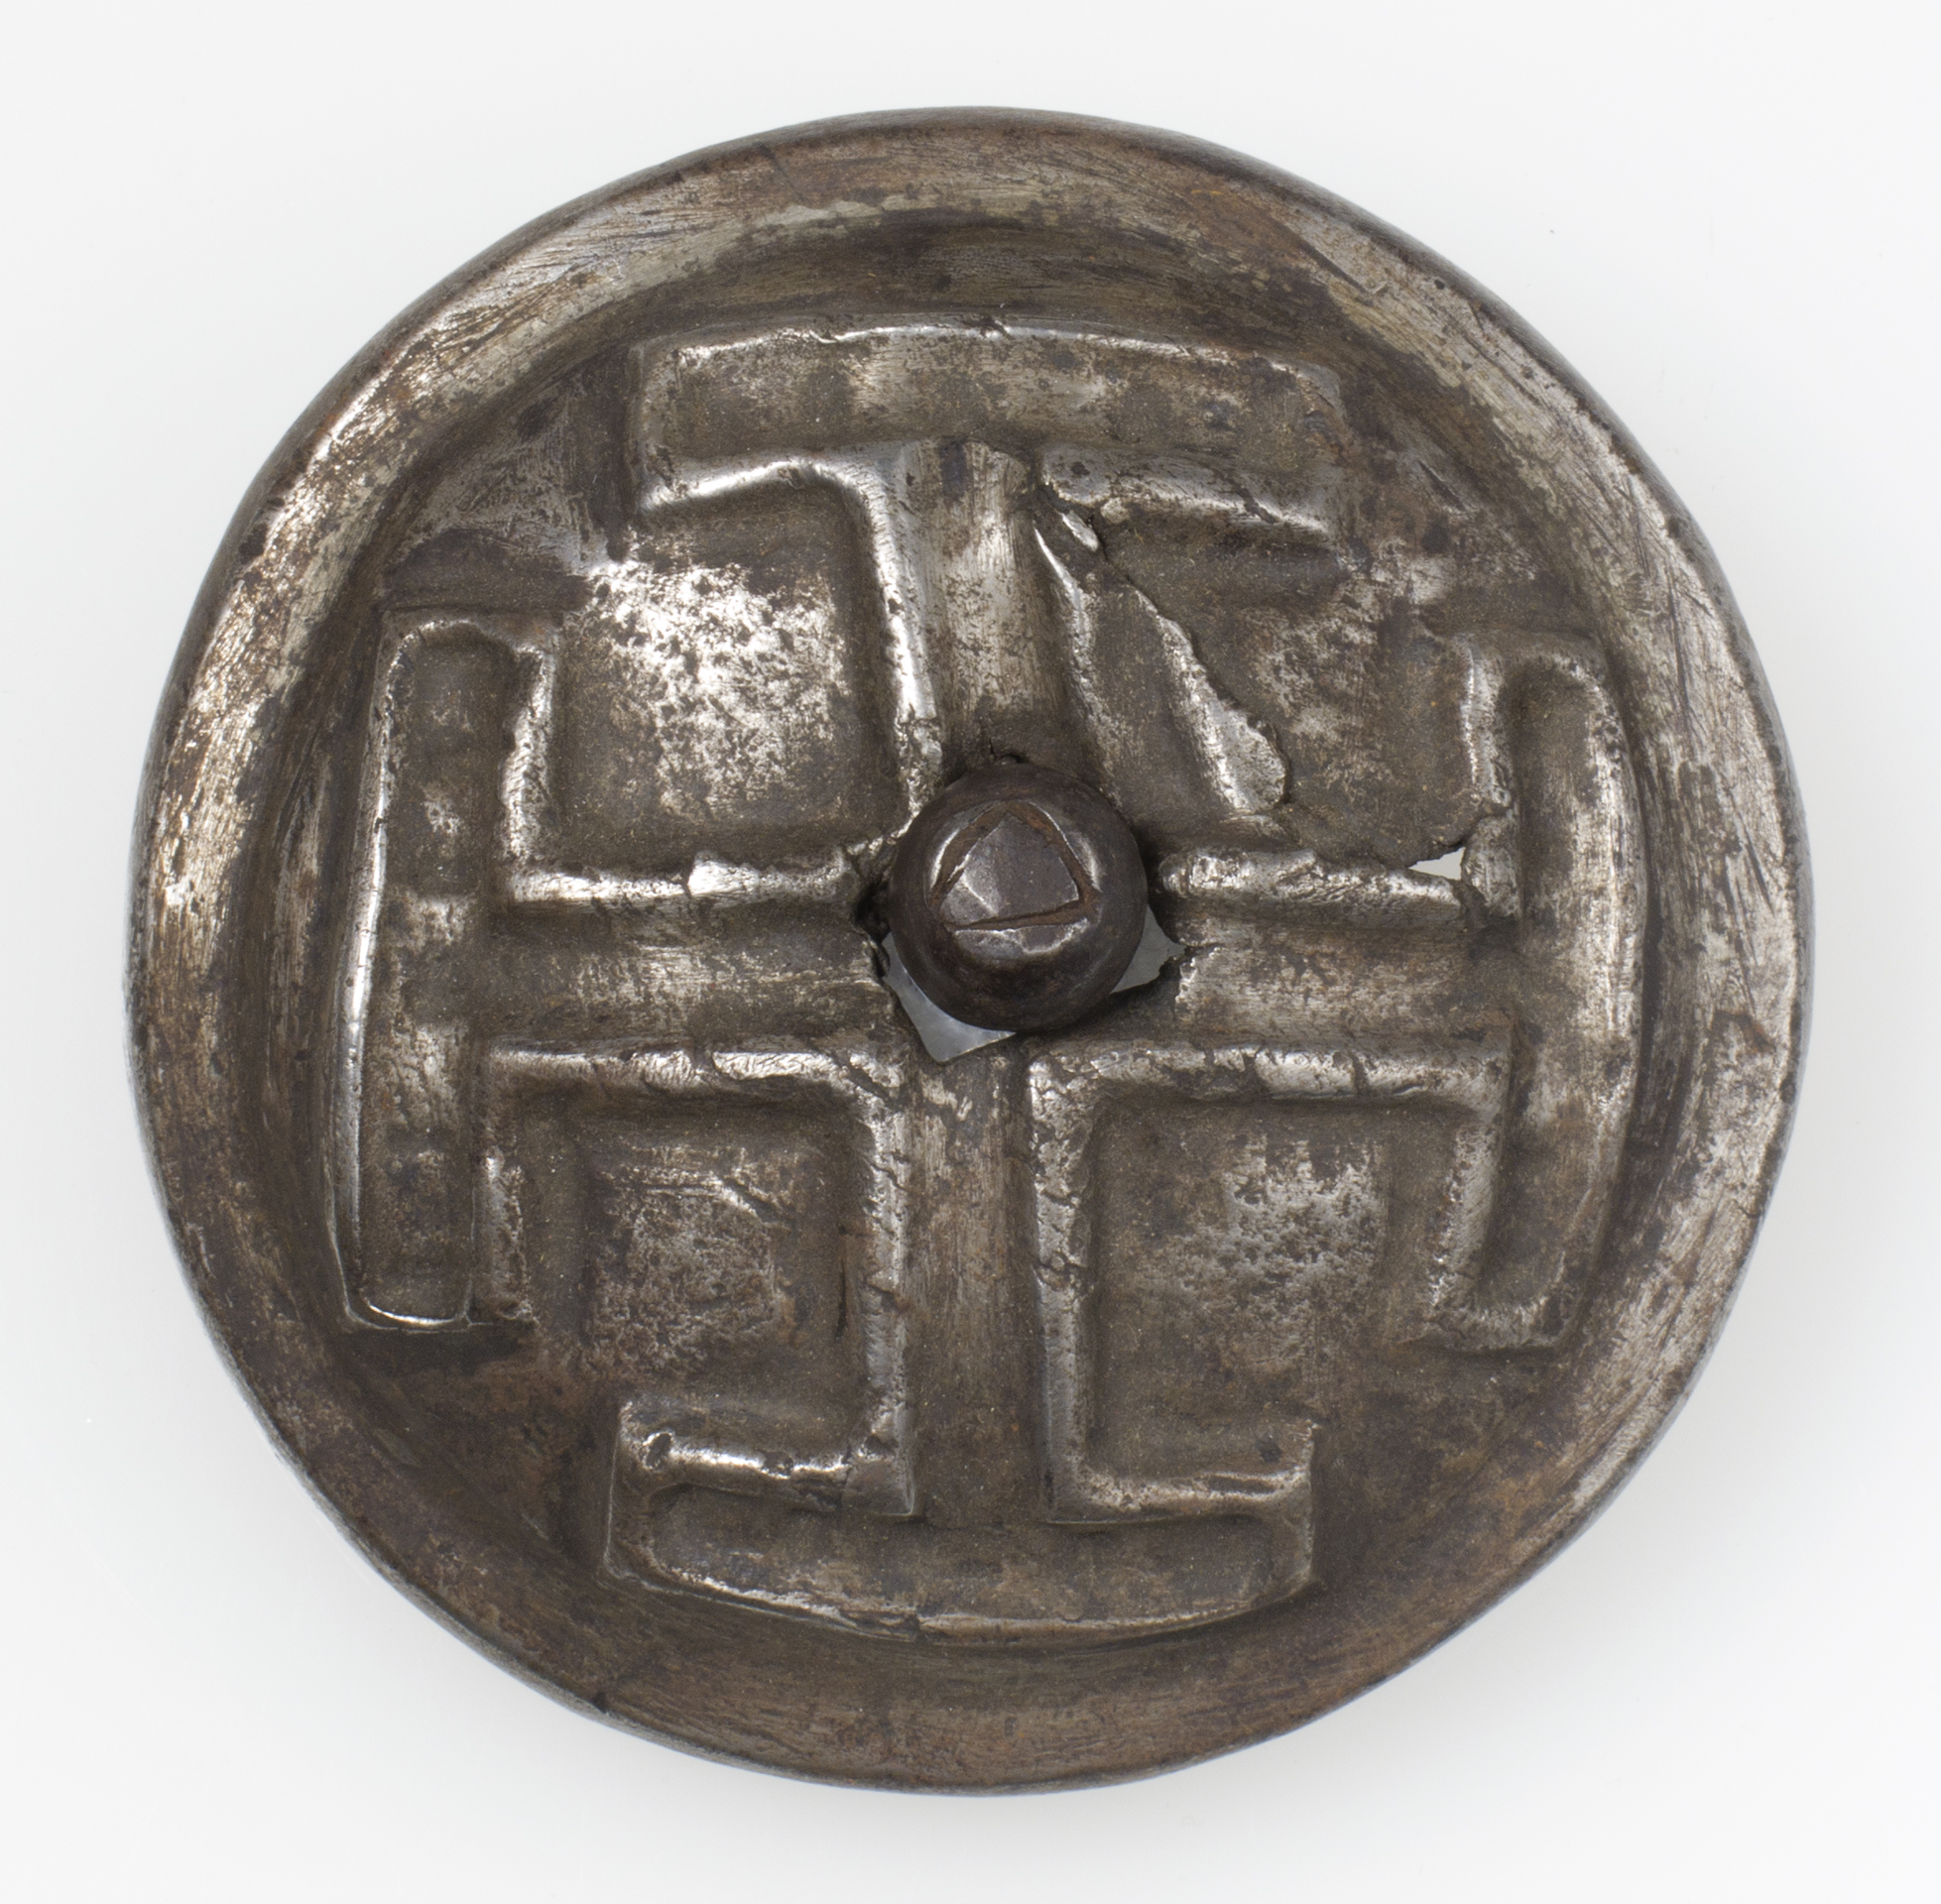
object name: plate and nail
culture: european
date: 1401-1600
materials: iron